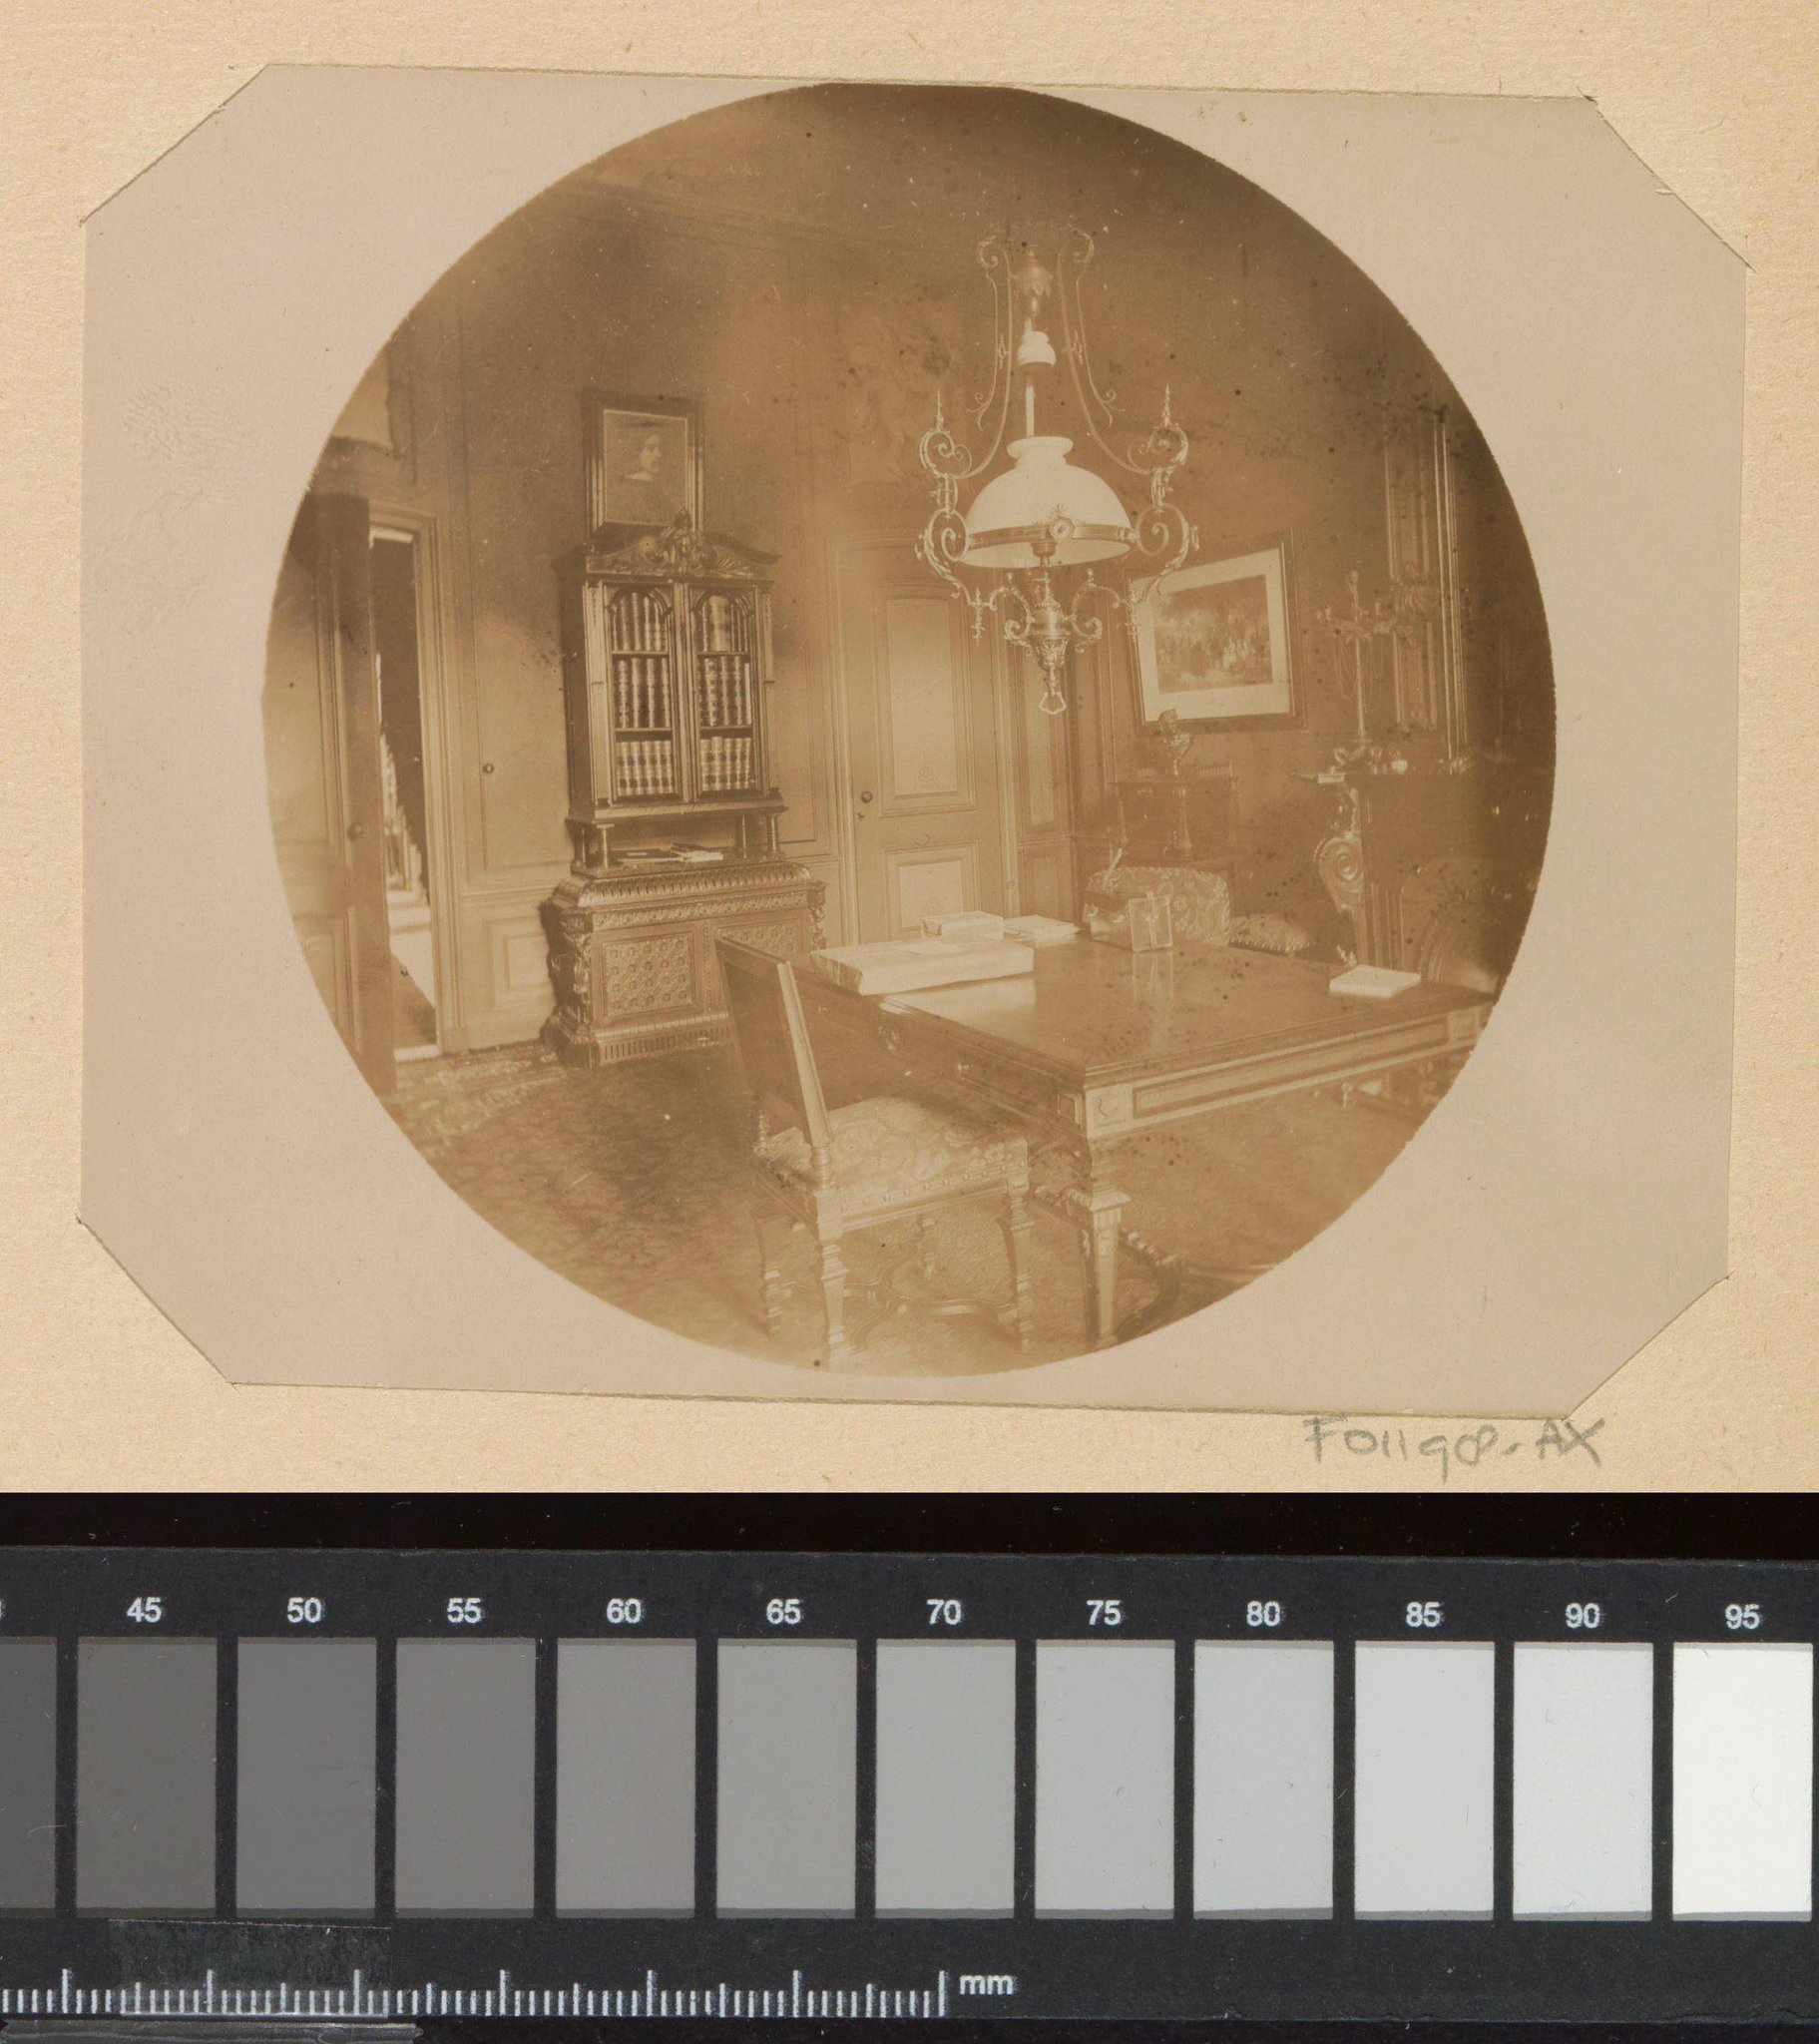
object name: album leaf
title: Interieur van het huis aan Herengracht 258, Amsterdam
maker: johanna margaretha piek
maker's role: fotograaf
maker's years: 1870-1947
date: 1889-1893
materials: paper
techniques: gelatin silver print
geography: amsterdam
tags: urban housing - aa - civic architecture: inside, amsterdam